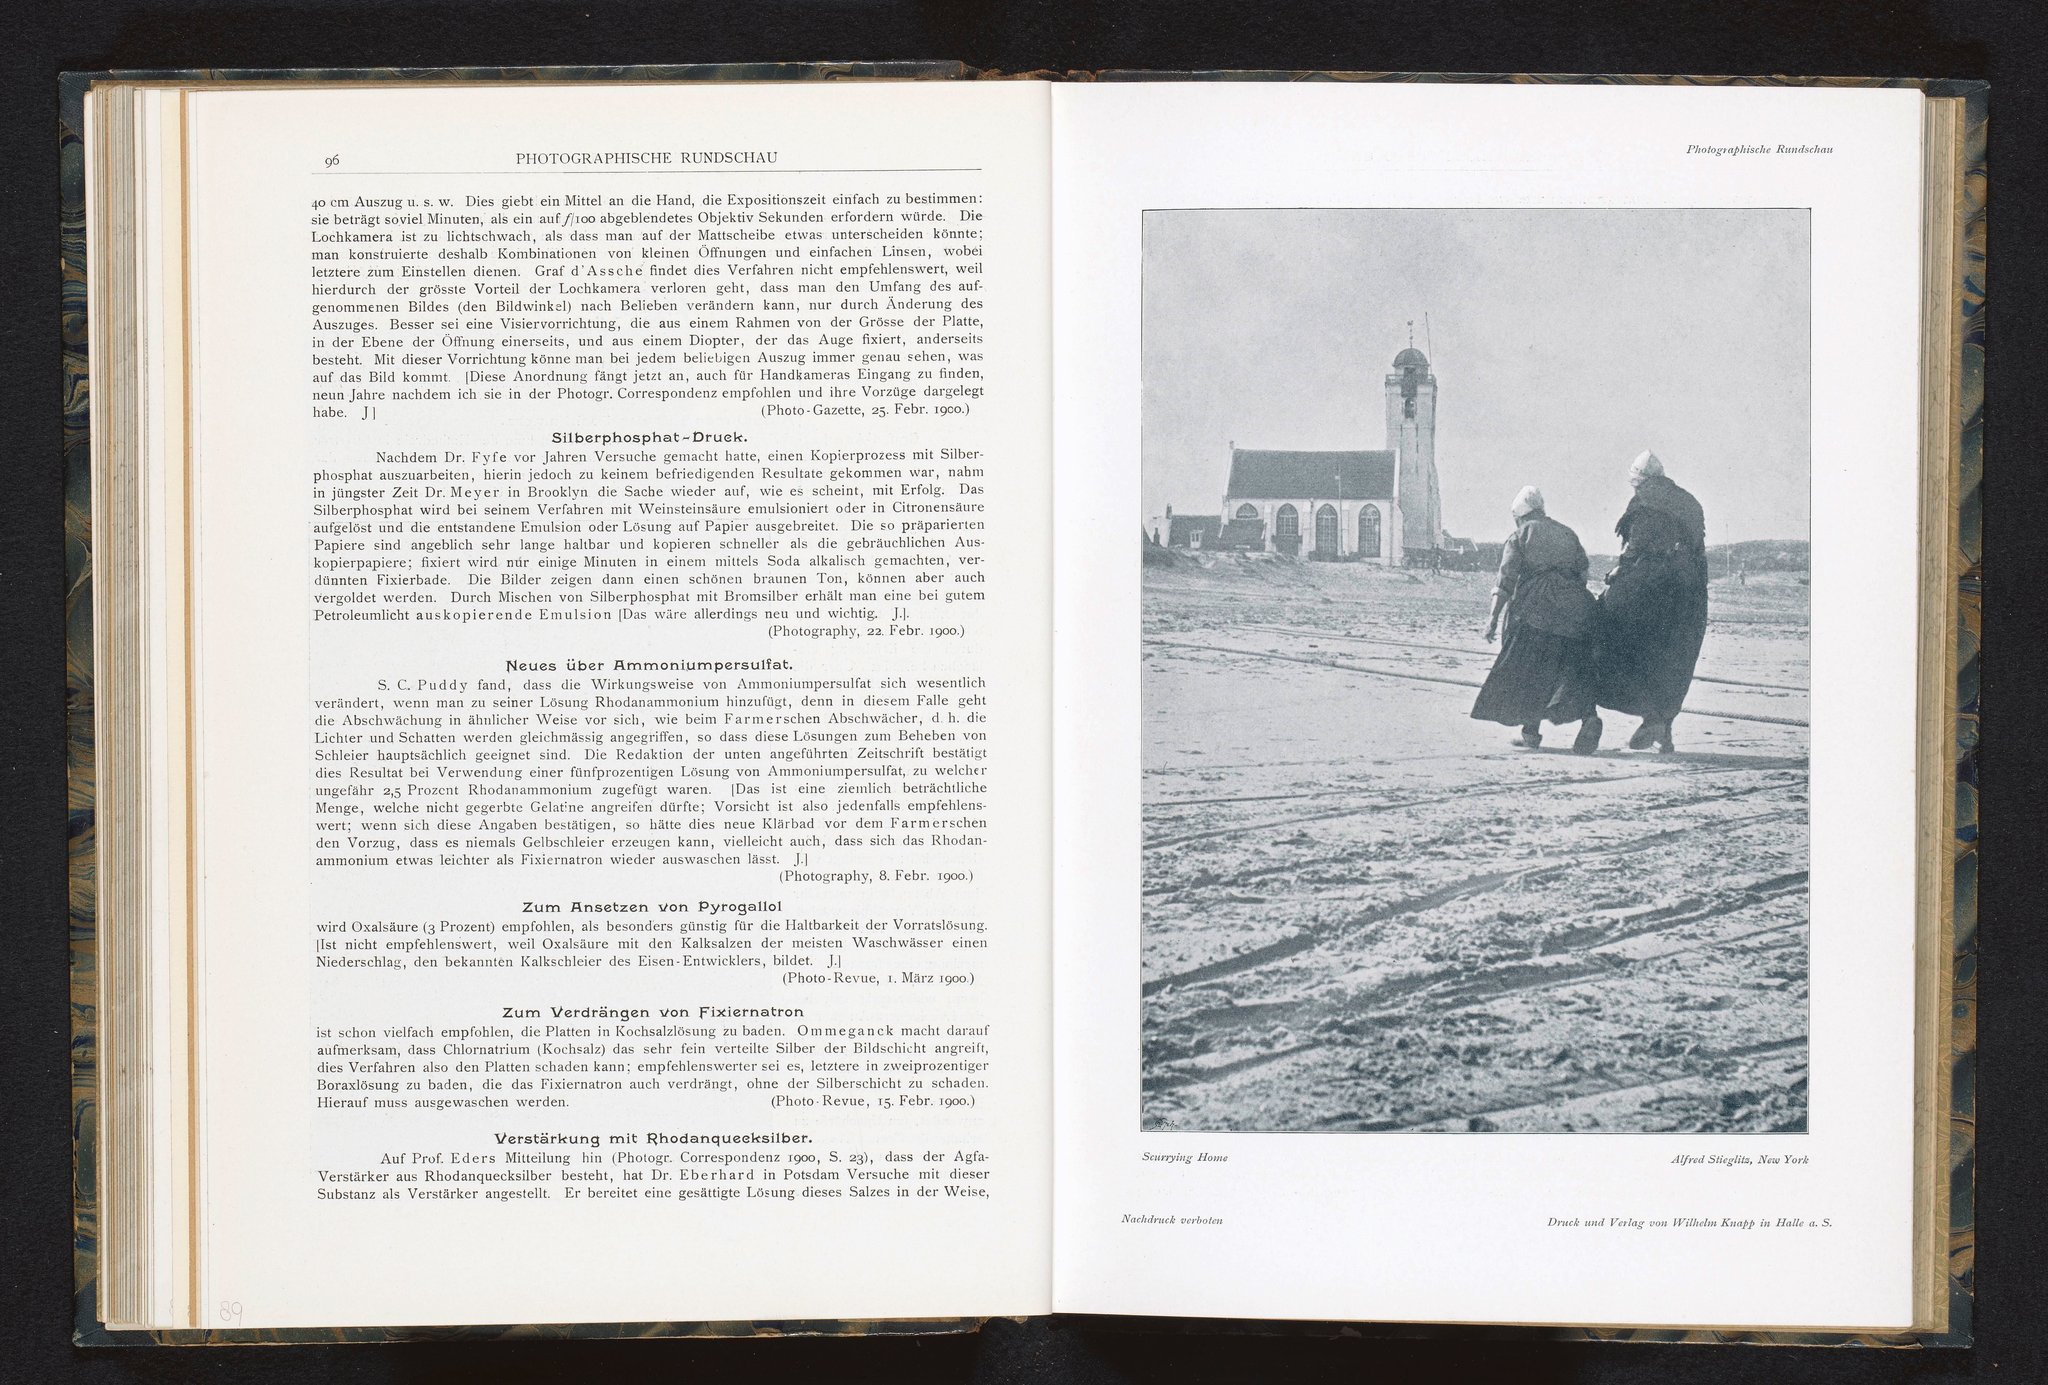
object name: page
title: Scurrying Home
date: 1895-1900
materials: paper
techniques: autotype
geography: halle an der saale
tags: church (exterior), beach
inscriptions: monogram: ‘[...]’, inscription: ‘Nachdruck verboten’